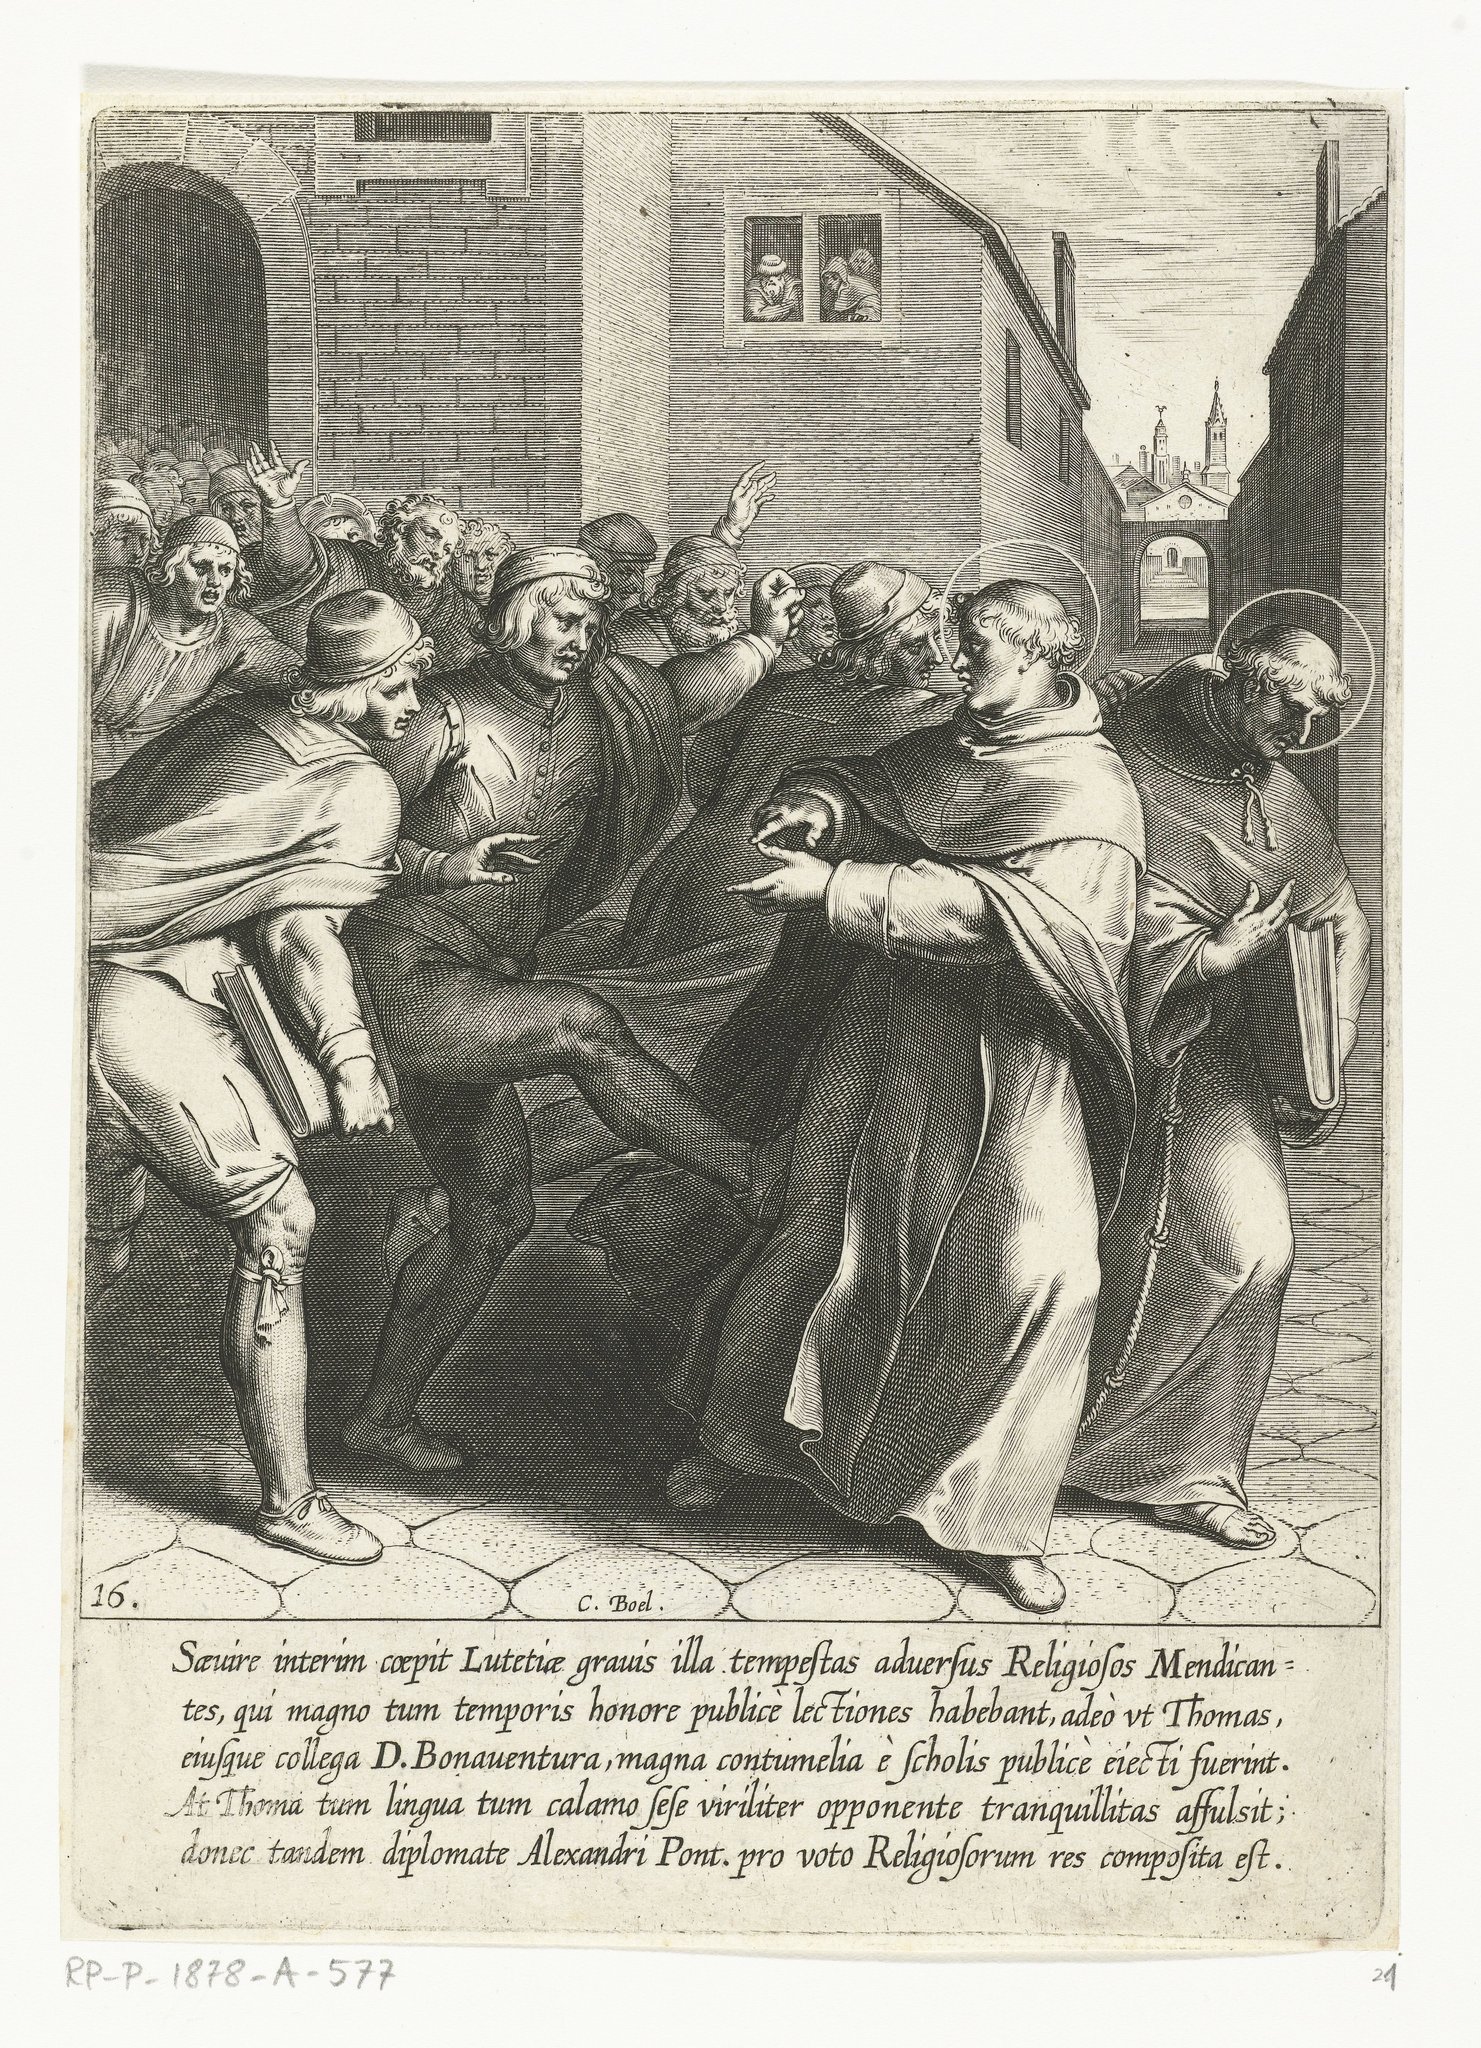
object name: print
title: Thomas en de heilige Bonaventura worden uit de universiteit verdreven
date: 1610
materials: paper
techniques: engraving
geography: southern netherlands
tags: thomas van aquino, bonaventura, cardinal bishop of albano and minister general of the franciscan order; possible attributes: book, cardinal's hat (sometimes hanging from a tree), crucifix (sometimes flowering), the dominican theologian, 'angelic doctor' thomas of aquino; possible attributes: book, (chain with) sun, dove, girdle of chastity, lily, model of church, monstrance (or chalice), mitre (under feet), star (on breast)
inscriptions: collector's mark: Lugt 2228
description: De heilige Thomas en de heilige Bonaventura worden in Parijs door studenten uit de universiteit verdreven. Prent uit een serie van 30 prenten die het levensverhaal van Thomas van Aquino verbeelden. De prenten, naar ontwerp van en uitgegeven door Otto van Veen, zijn door C. Boel, E. van Paenderen, C. Galle en G. Swanenburgh vervaardigd